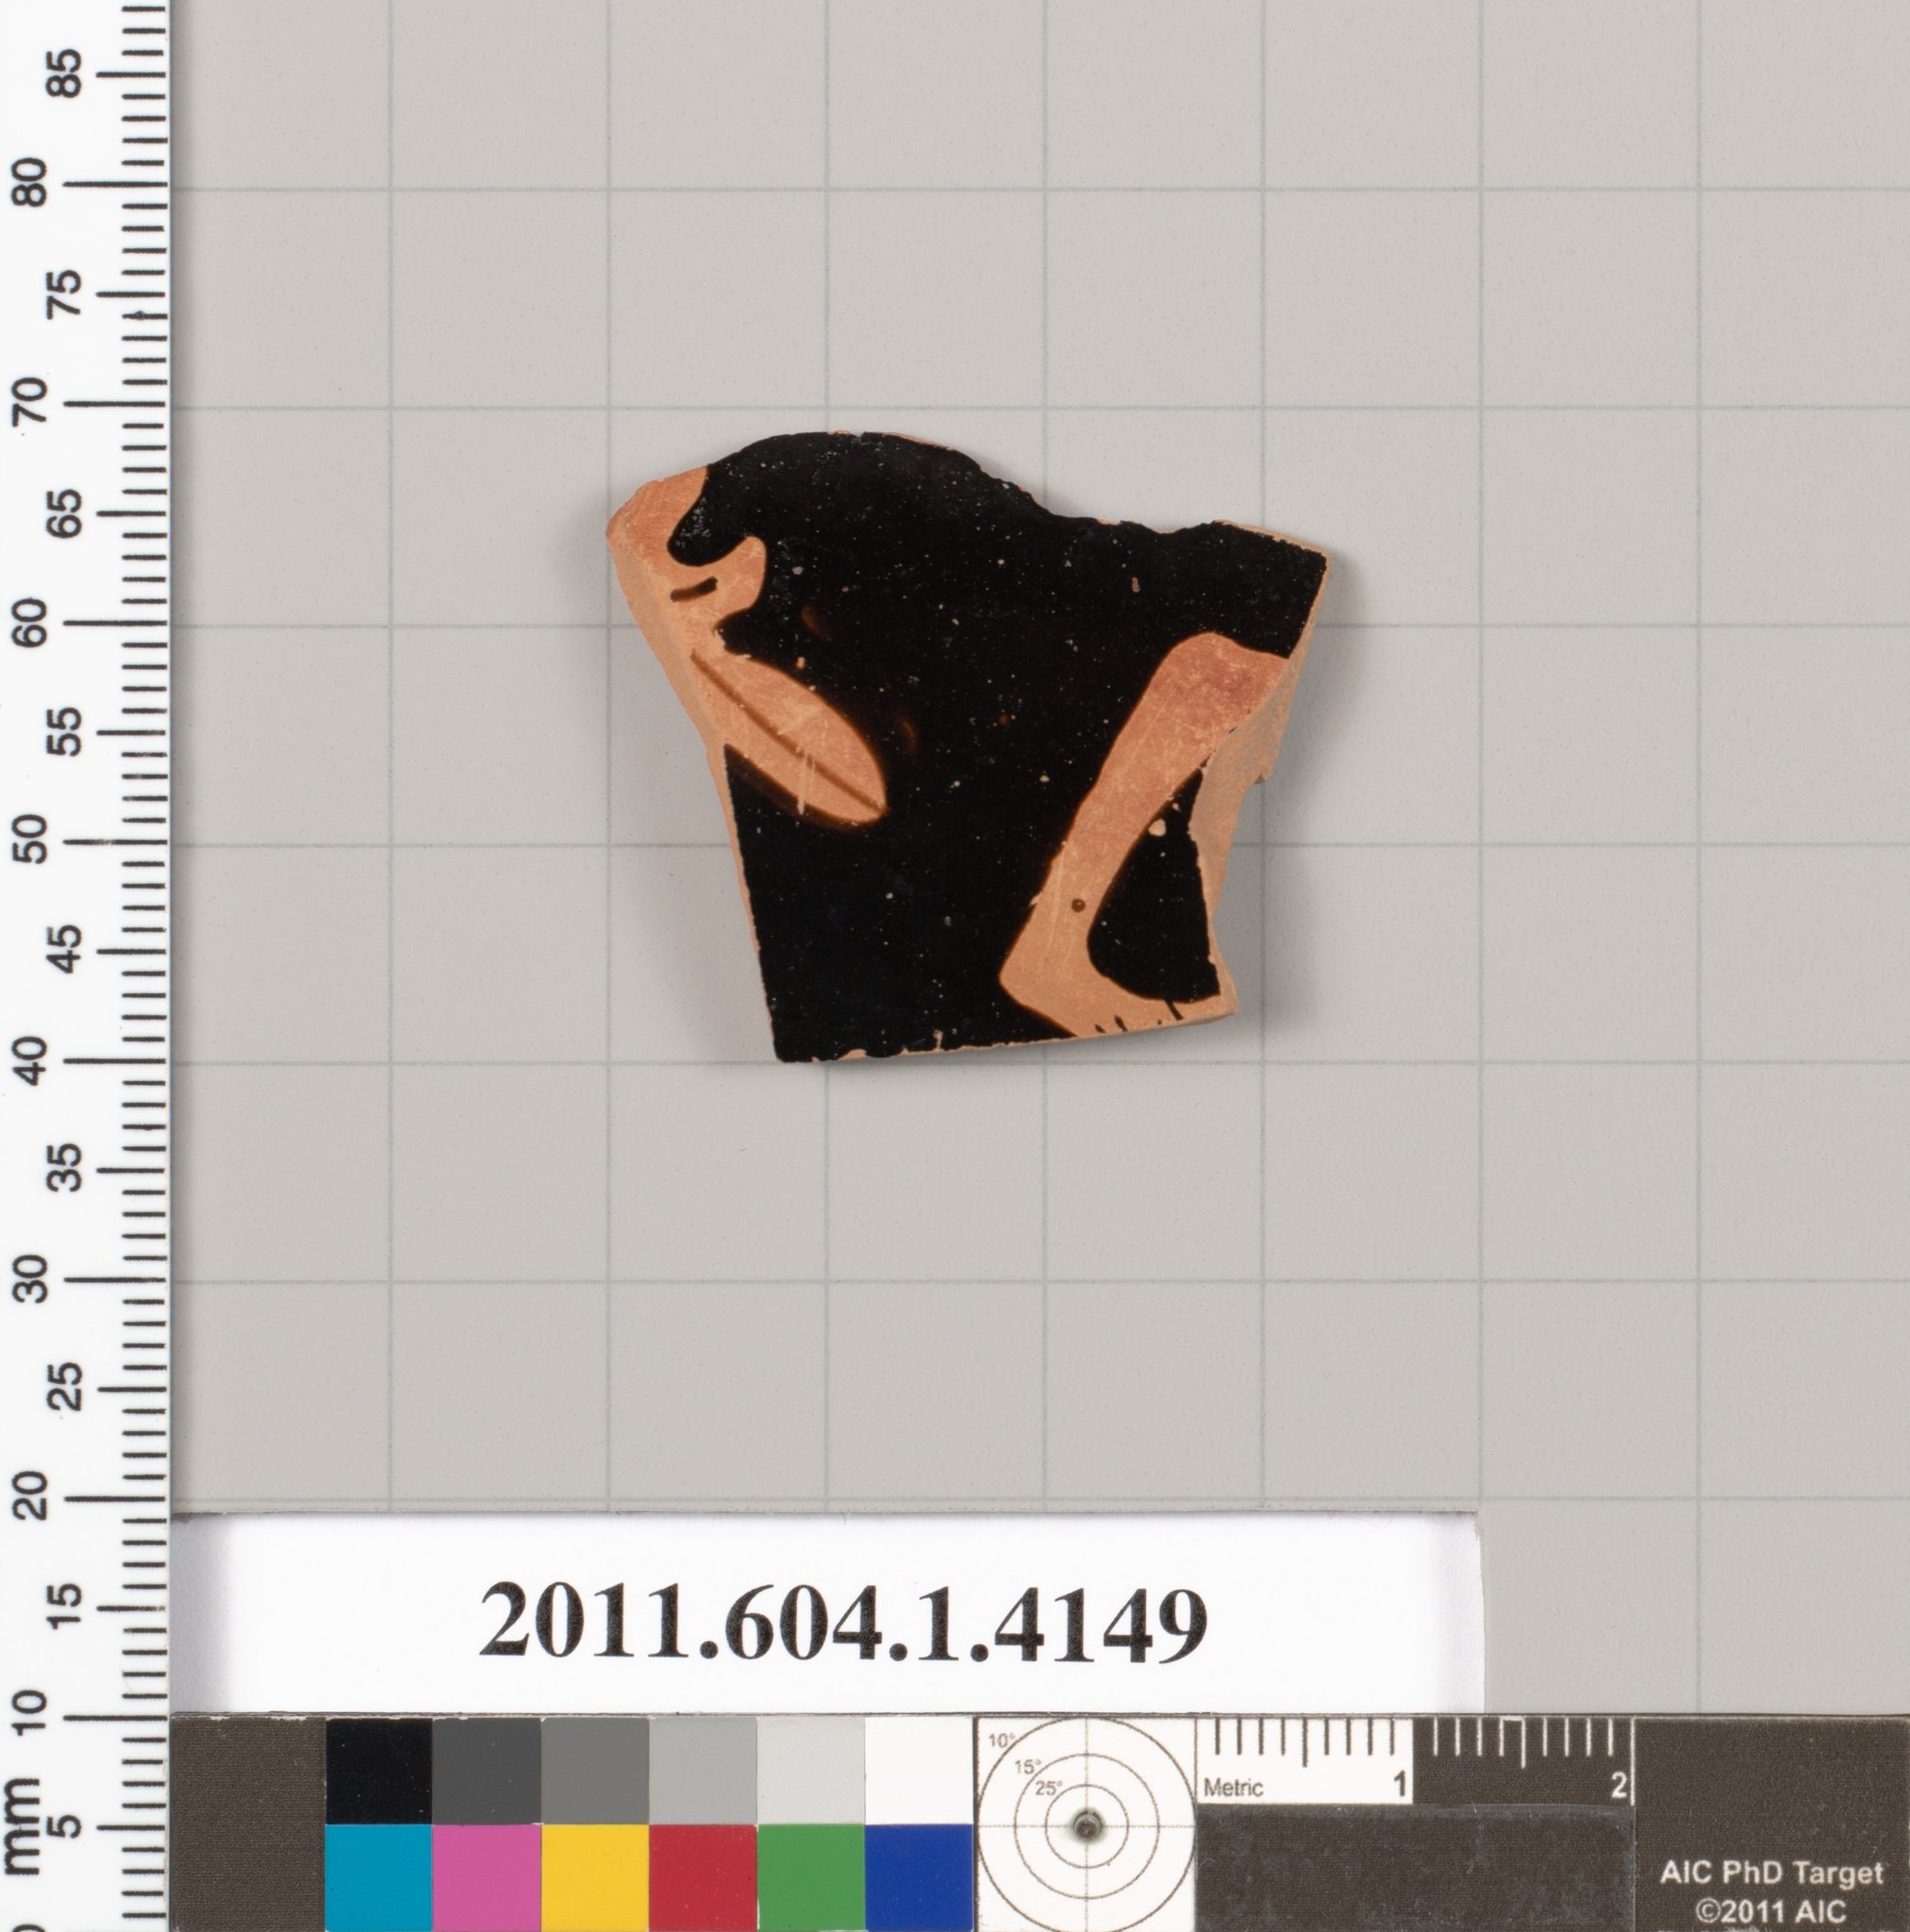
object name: kylix fragment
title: Terracotta fragment of a kylix (drinking cup)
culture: greek, attic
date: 475-451 BCE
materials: terracotta